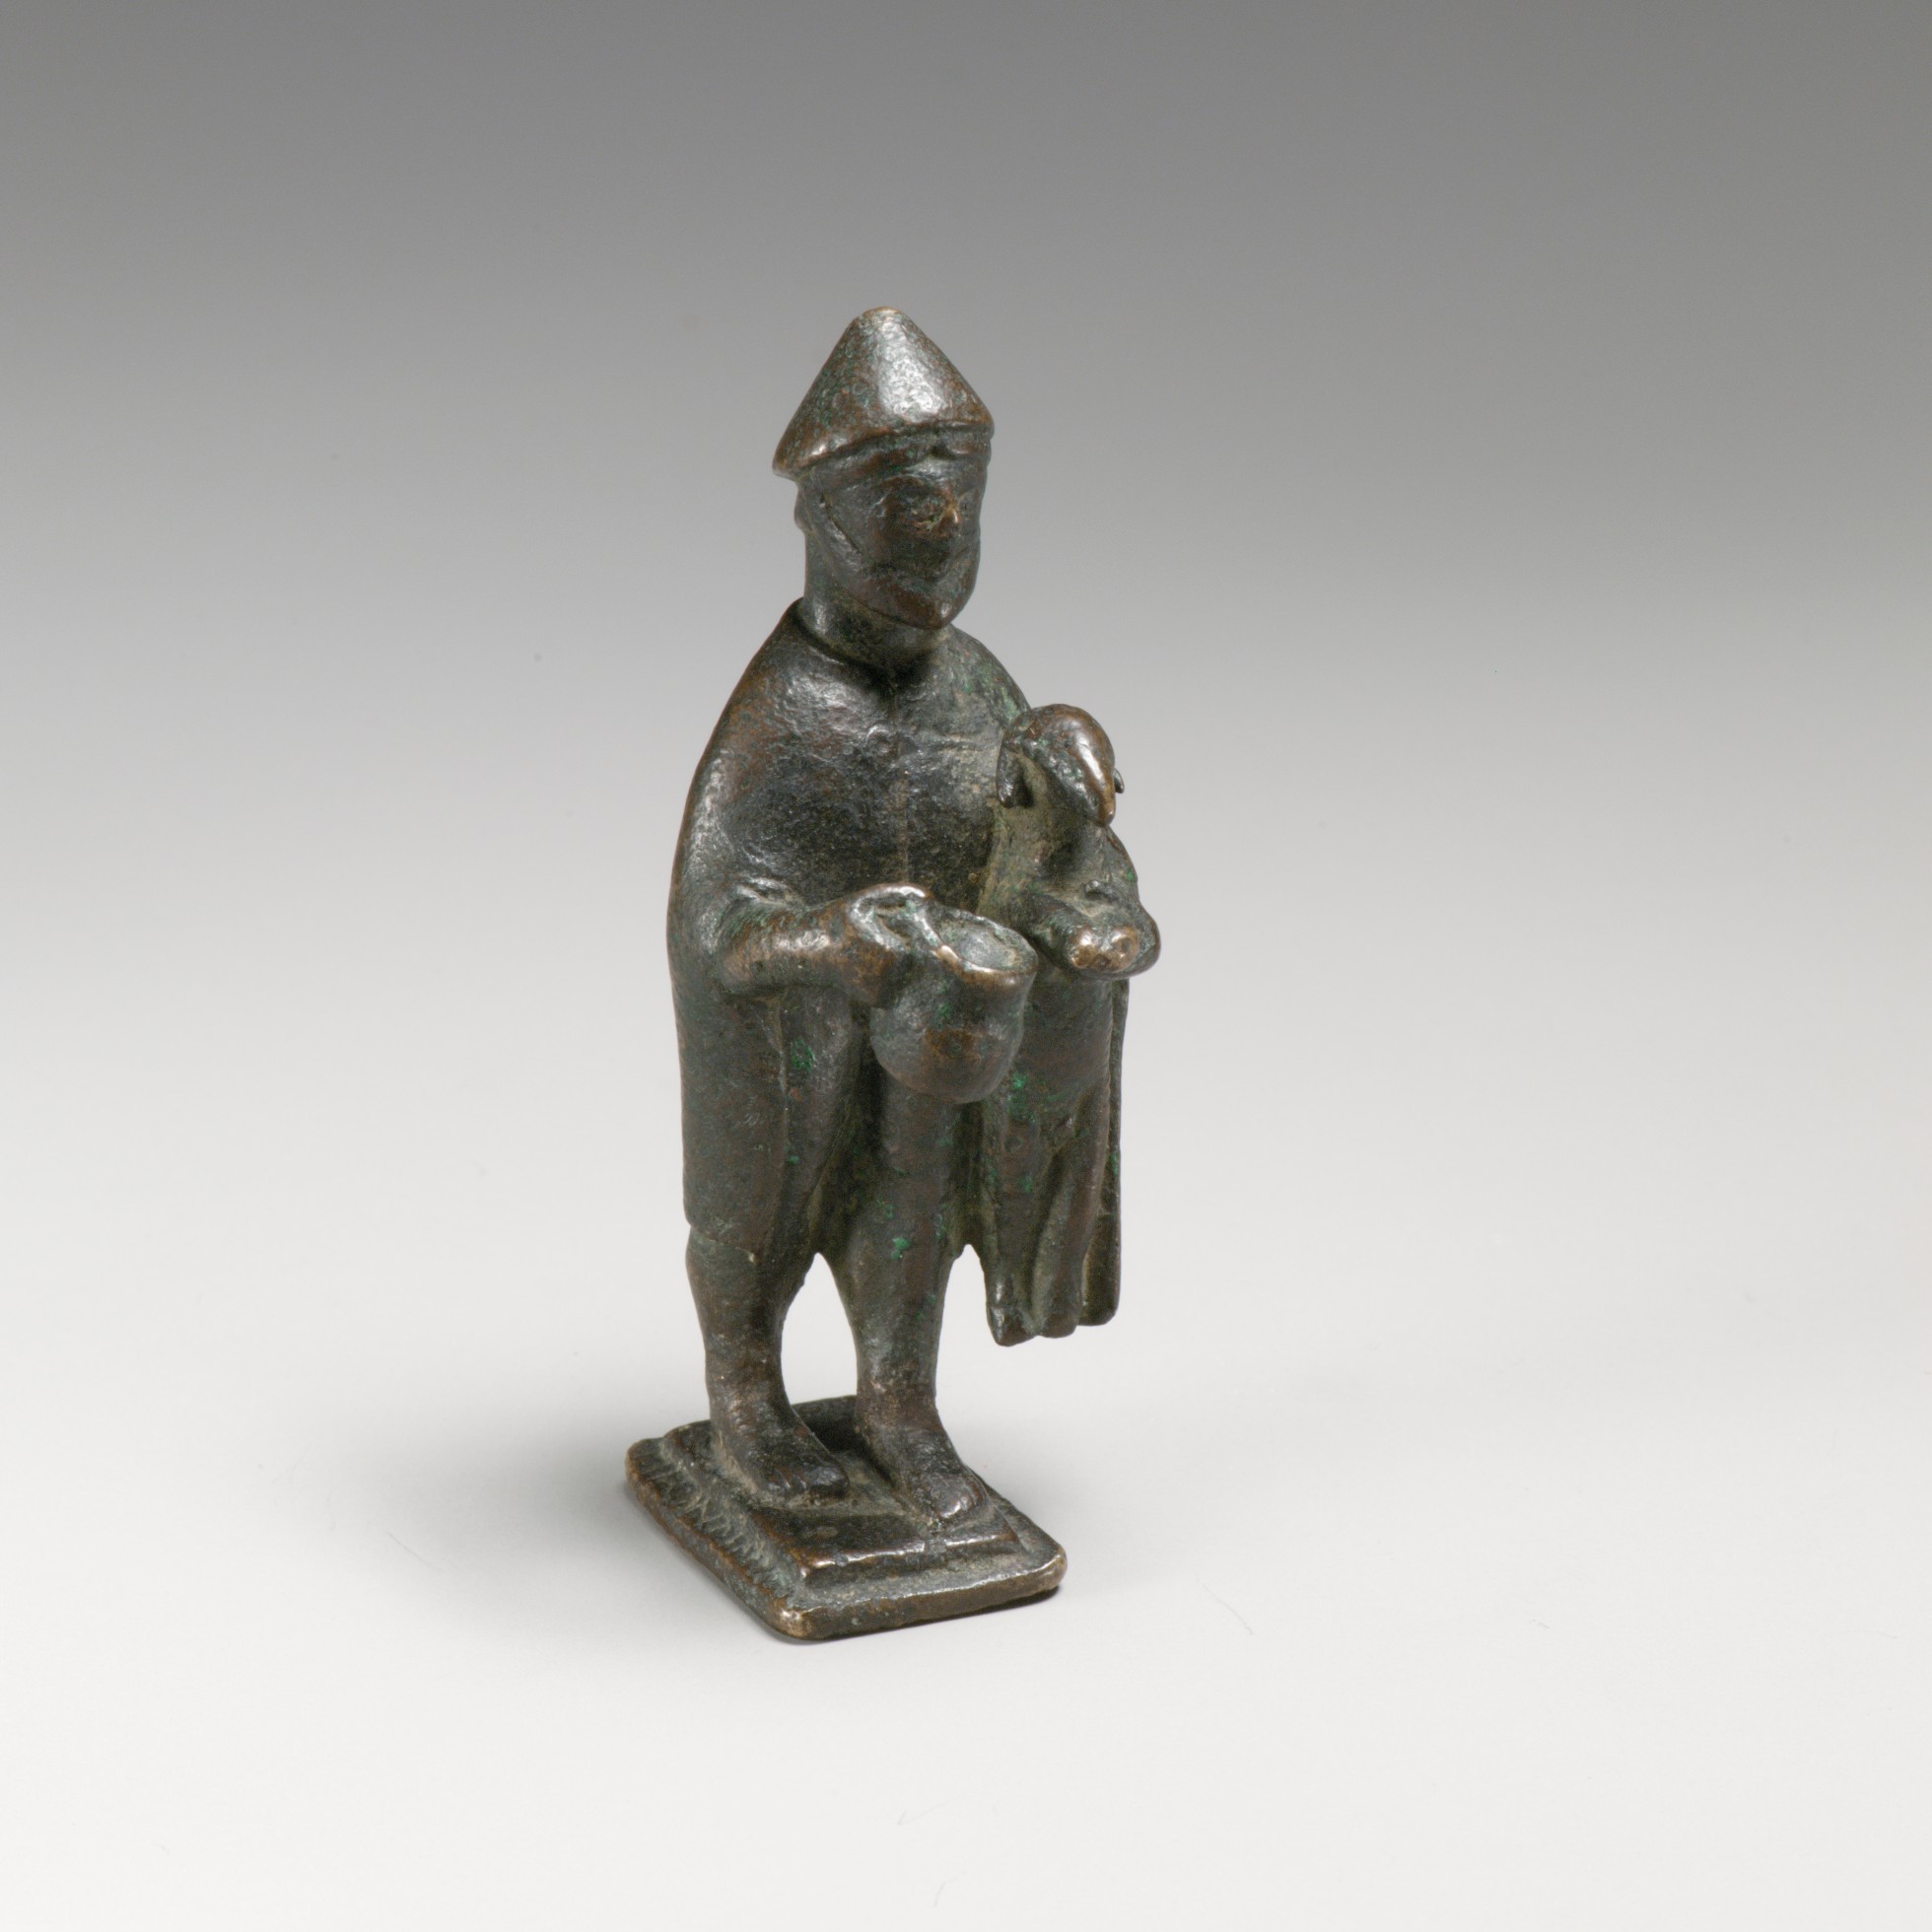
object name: statue of an arcadian shepherd holding ram and jug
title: Bronze statuette of a shepherd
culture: greek, arcadian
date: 525-500 BCE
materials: bronze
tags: shepherds